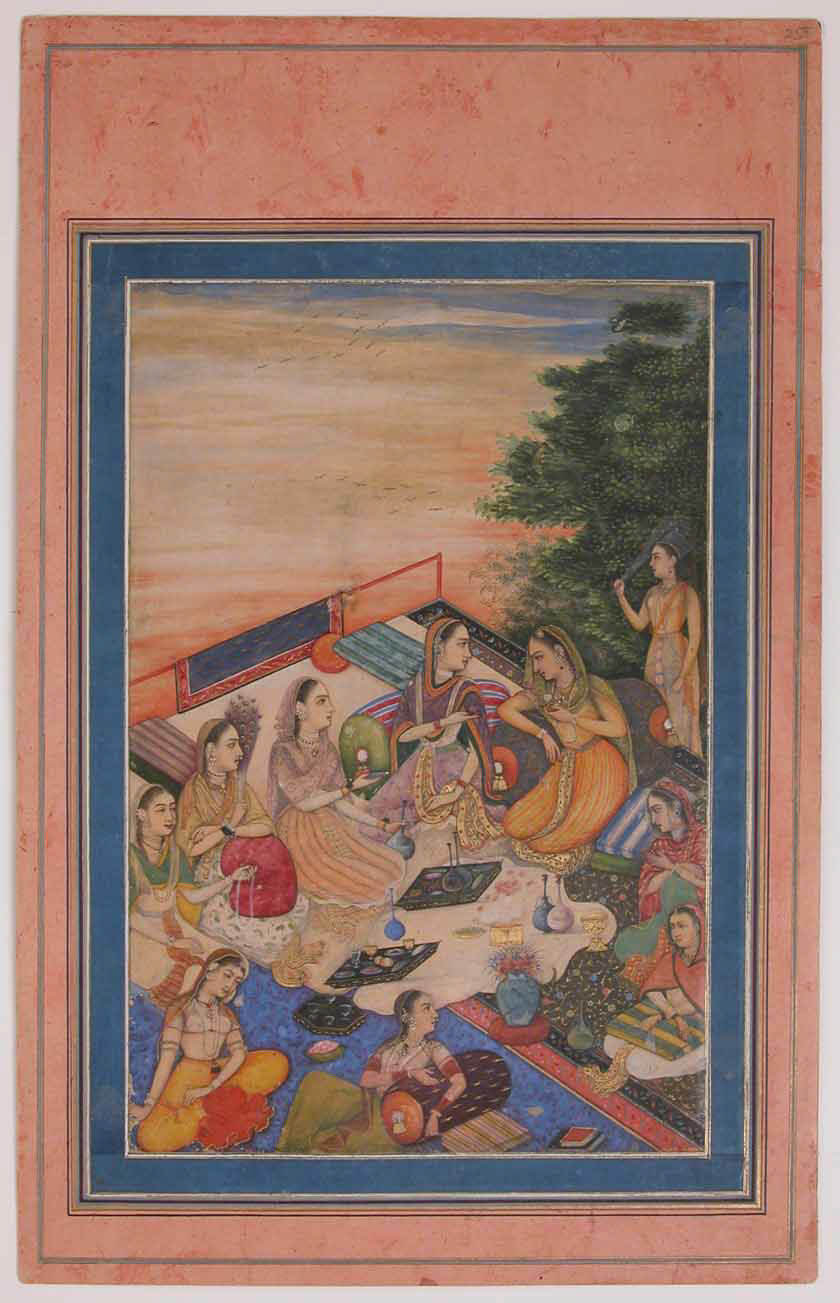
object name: illustrated album leaf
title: "Women Feasting on a Balcony", Folio from the Davis Album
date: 1667-1733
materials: gold, ink, paper, watercolor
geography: india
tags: women